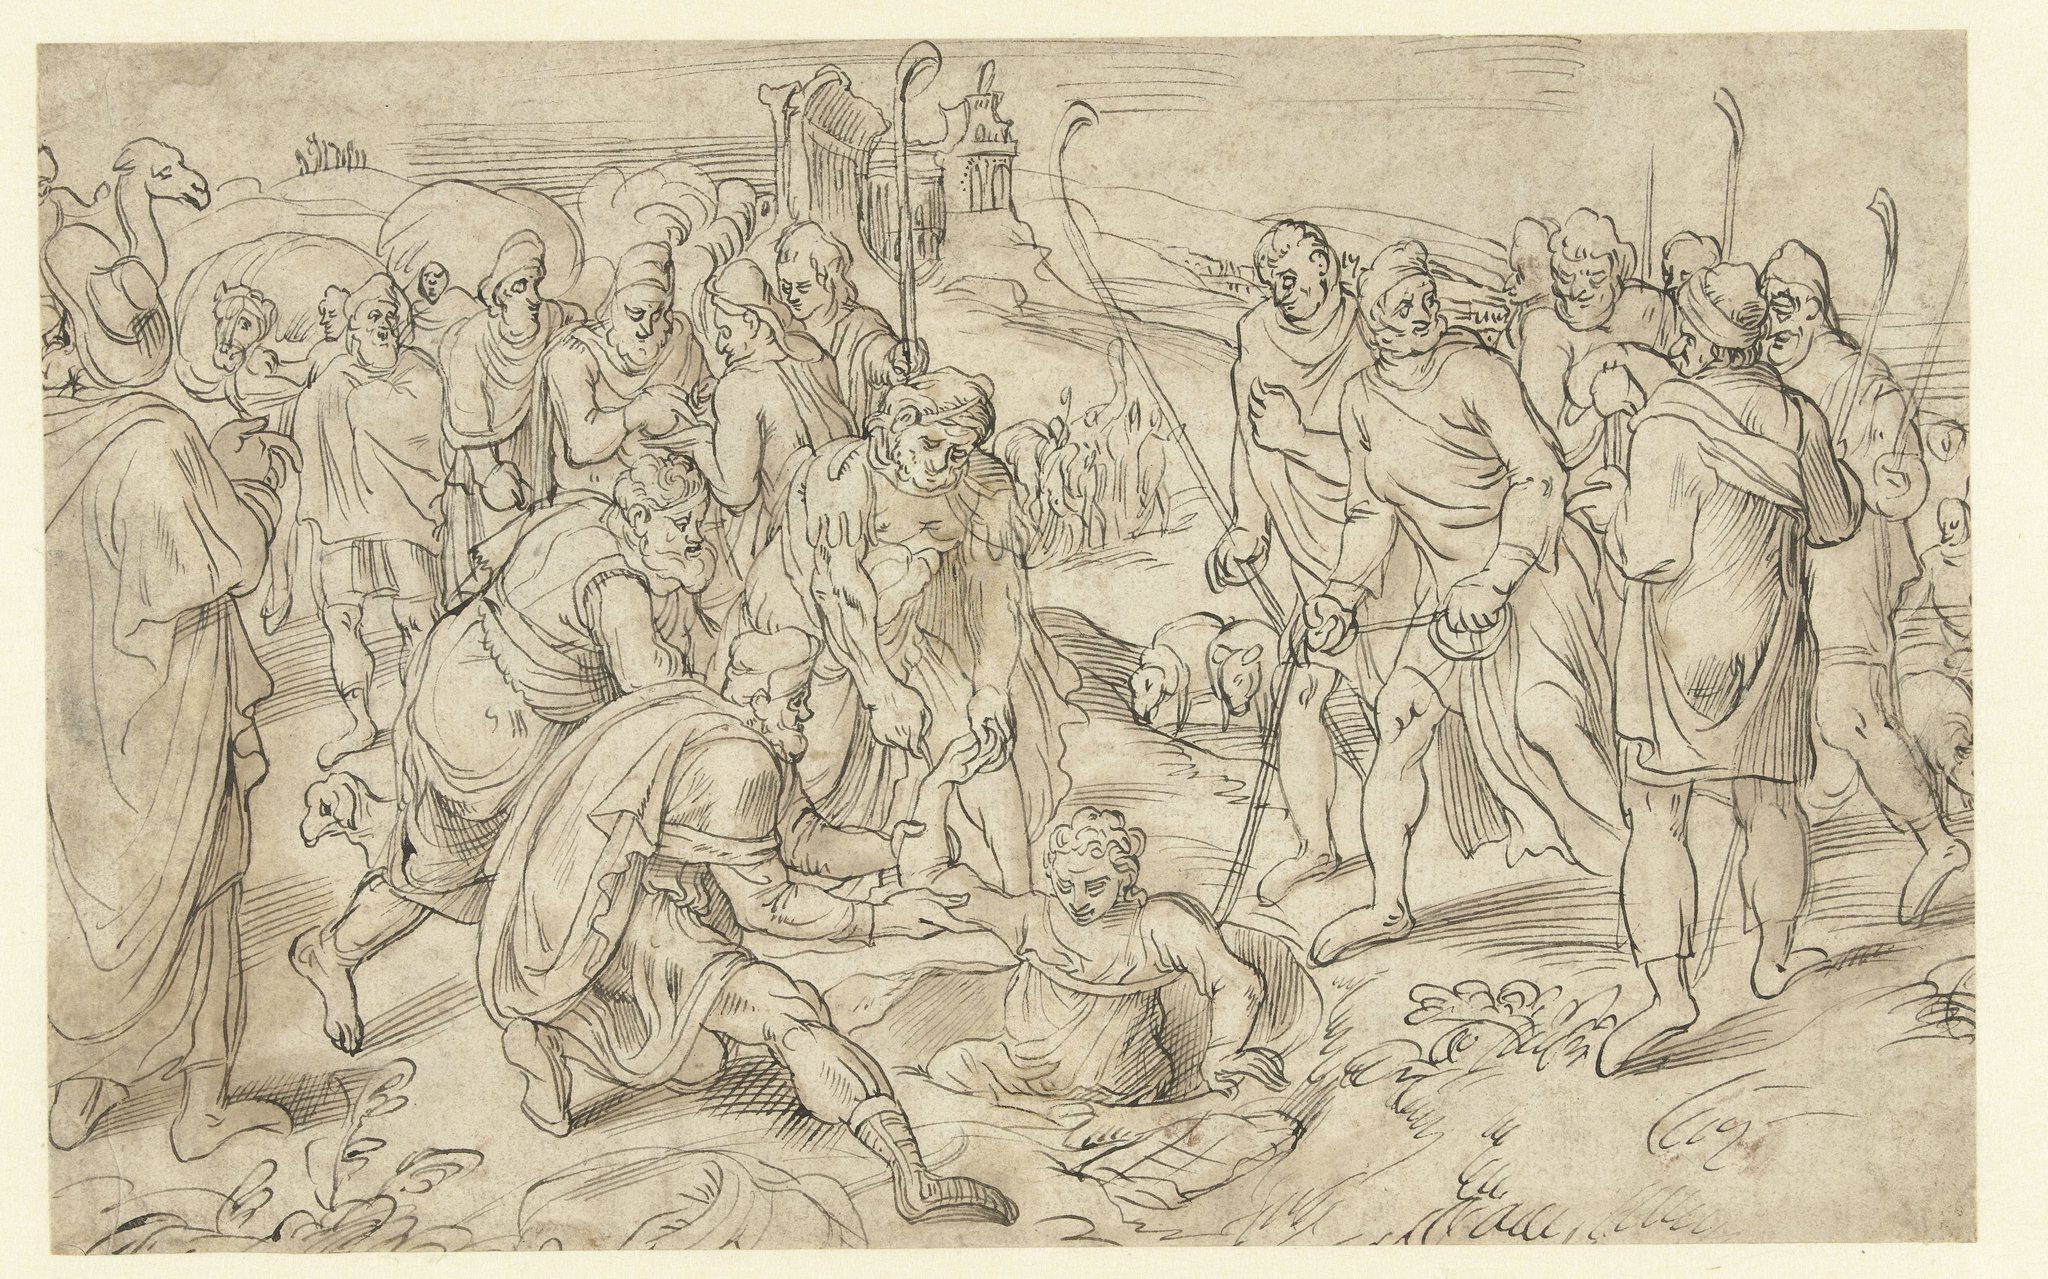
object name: drawing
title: Jozef door zijn broeders uit de put getrokken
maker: frans floris (i)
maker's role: draughtsman, print maker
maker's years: 1519-1570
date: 1530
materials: ink, paper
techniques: brush, pen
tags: joseph is pulled out of the pit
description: Jozef door zijn broeders uit de put getrokken